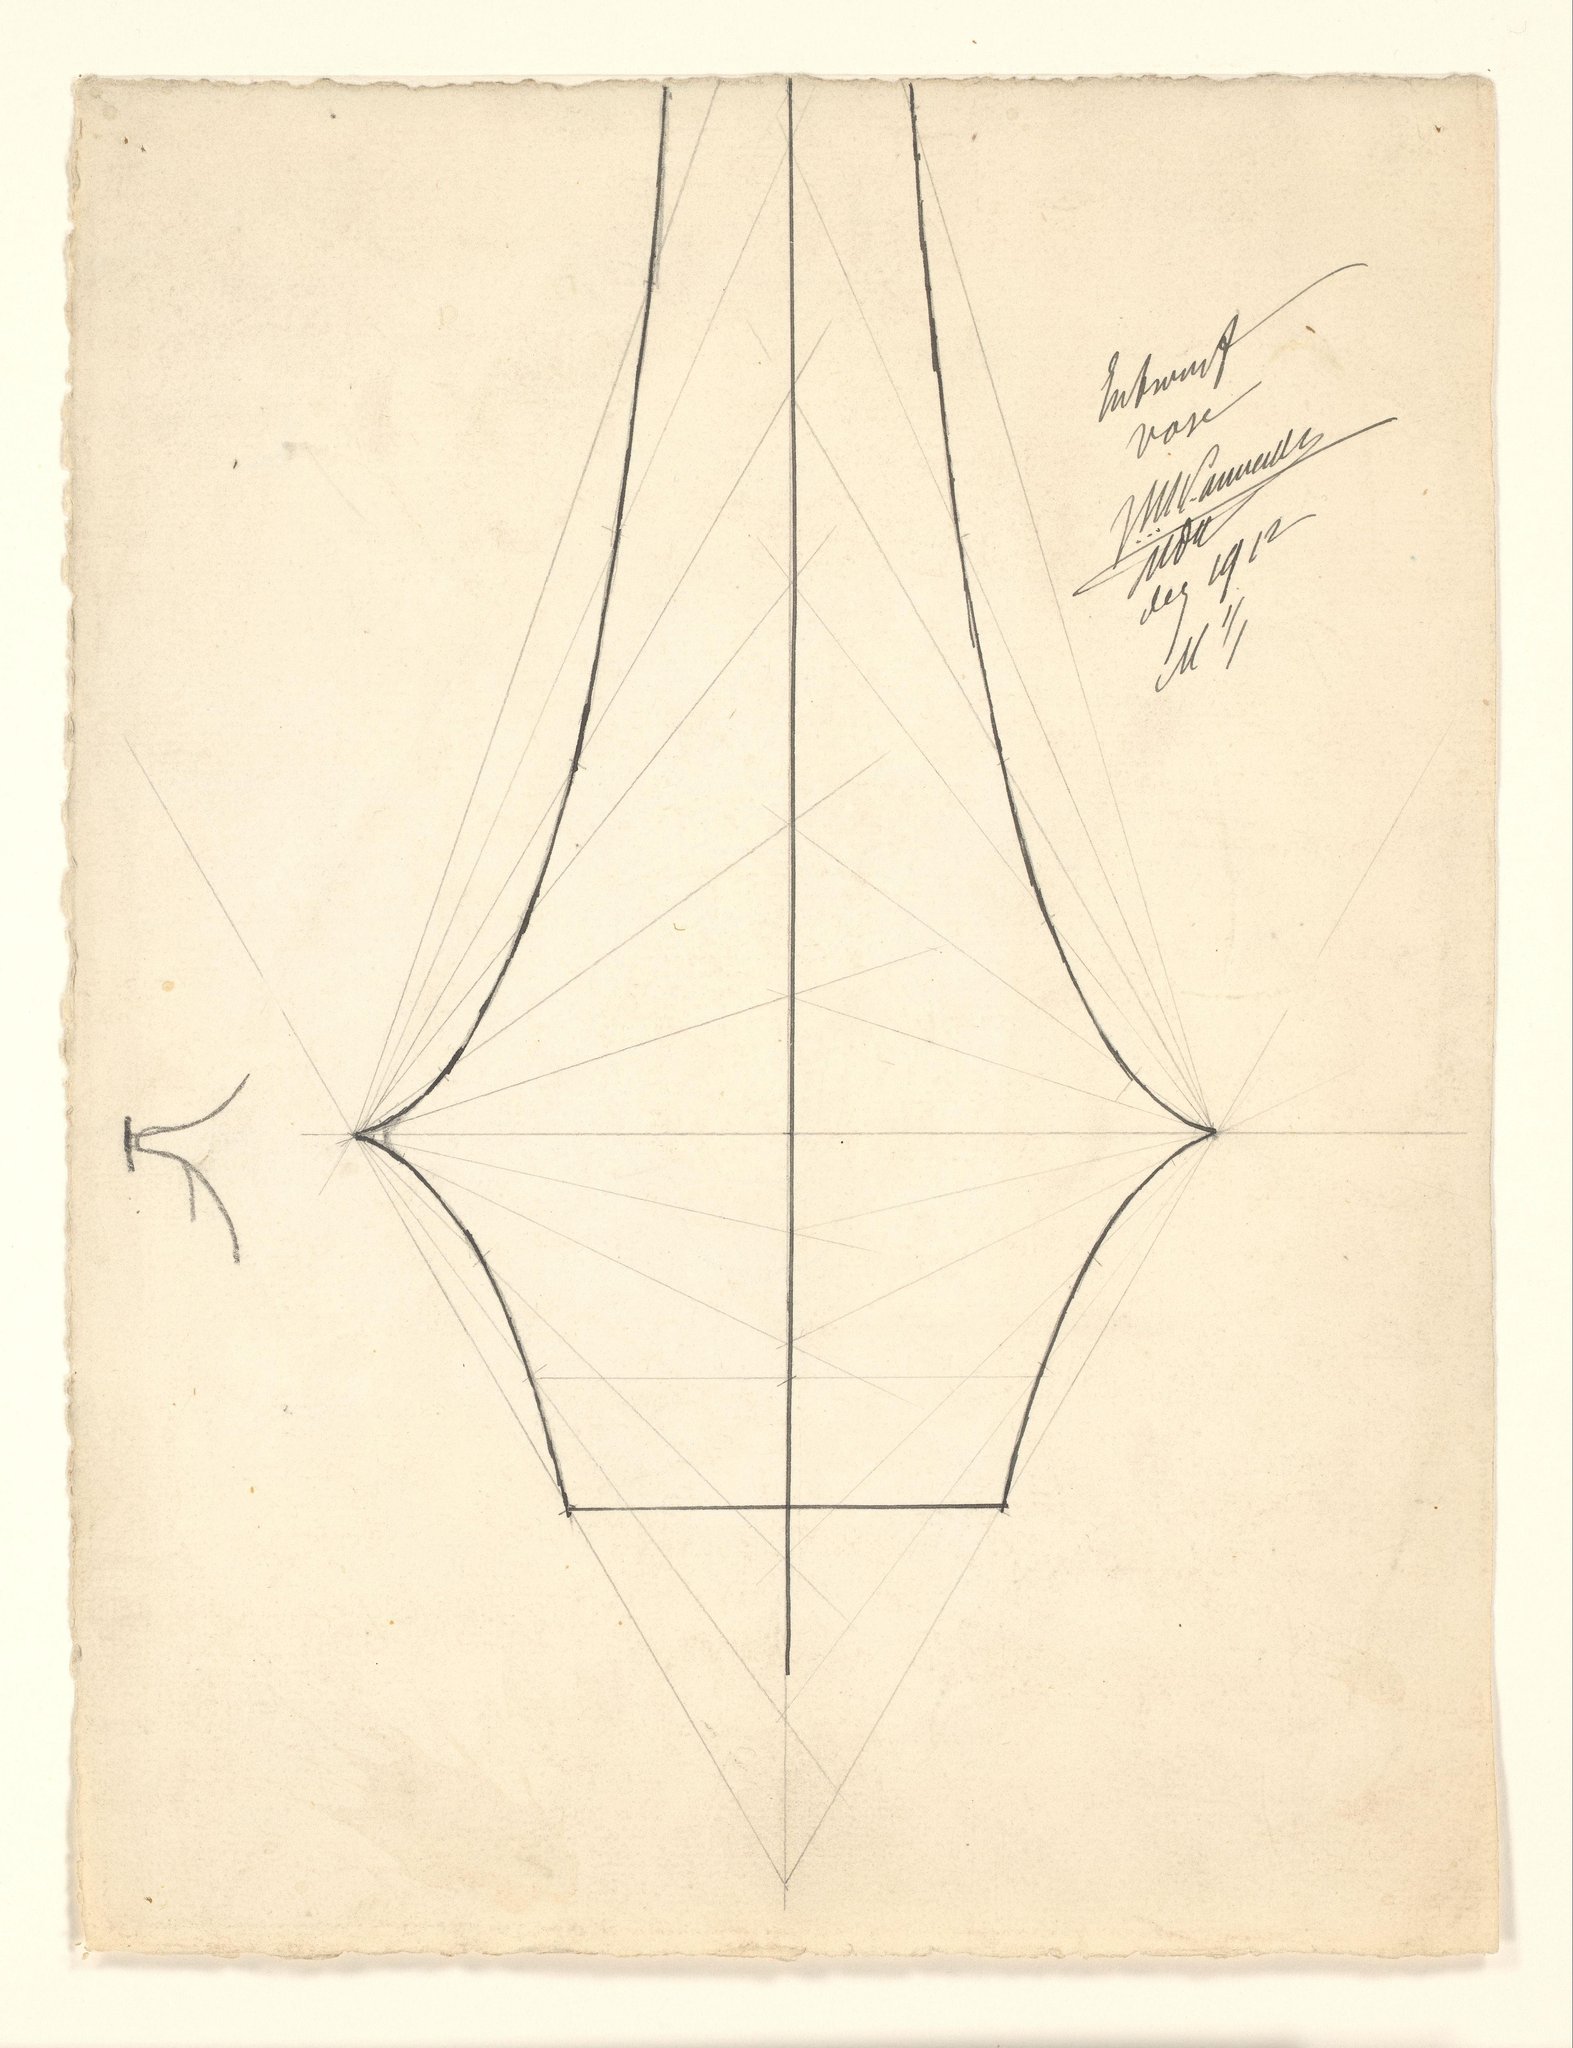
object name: drawing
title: Ontwerp voor een bloemenvaas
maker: mathieu lauweriks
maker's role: designer, draughtsman, print maker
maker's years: 1864-1932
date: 1874-1932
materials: ink, paper, pencil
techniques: pen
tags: container of ceramics: jar, jug, pot, vase